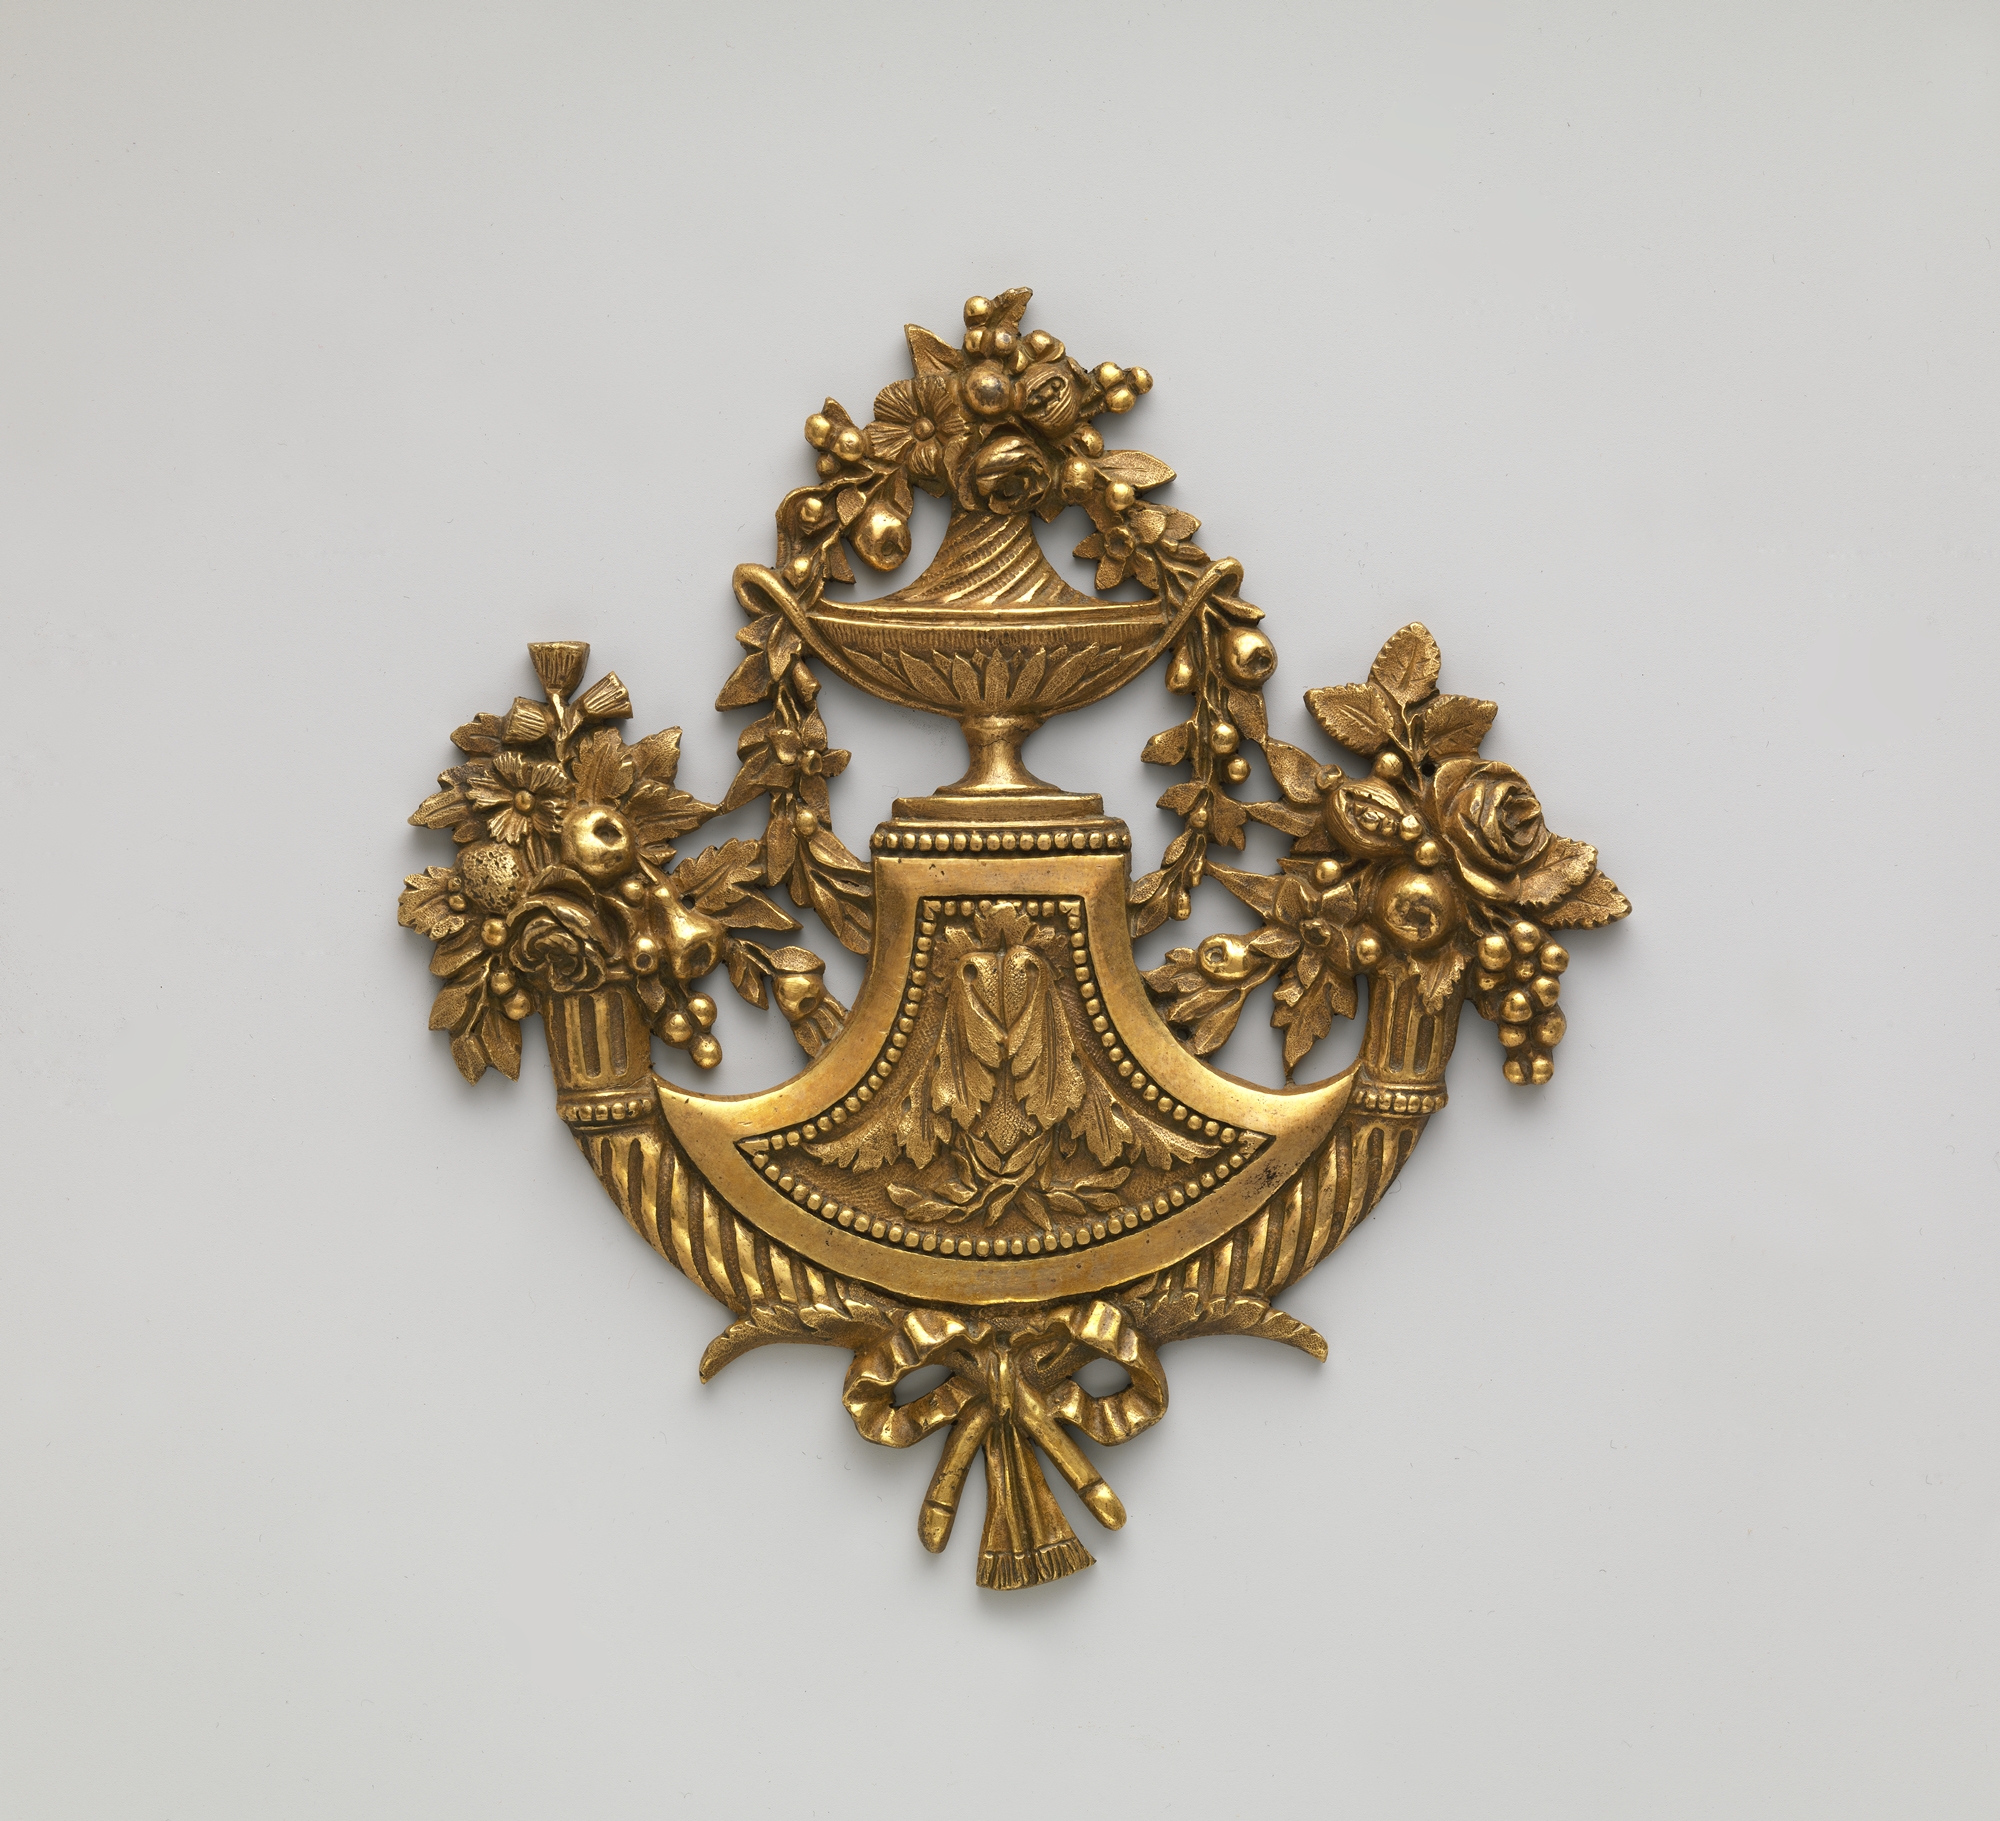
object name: panel ornament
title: Pair of panel ornaments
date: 1867-1900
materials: gilt bronze